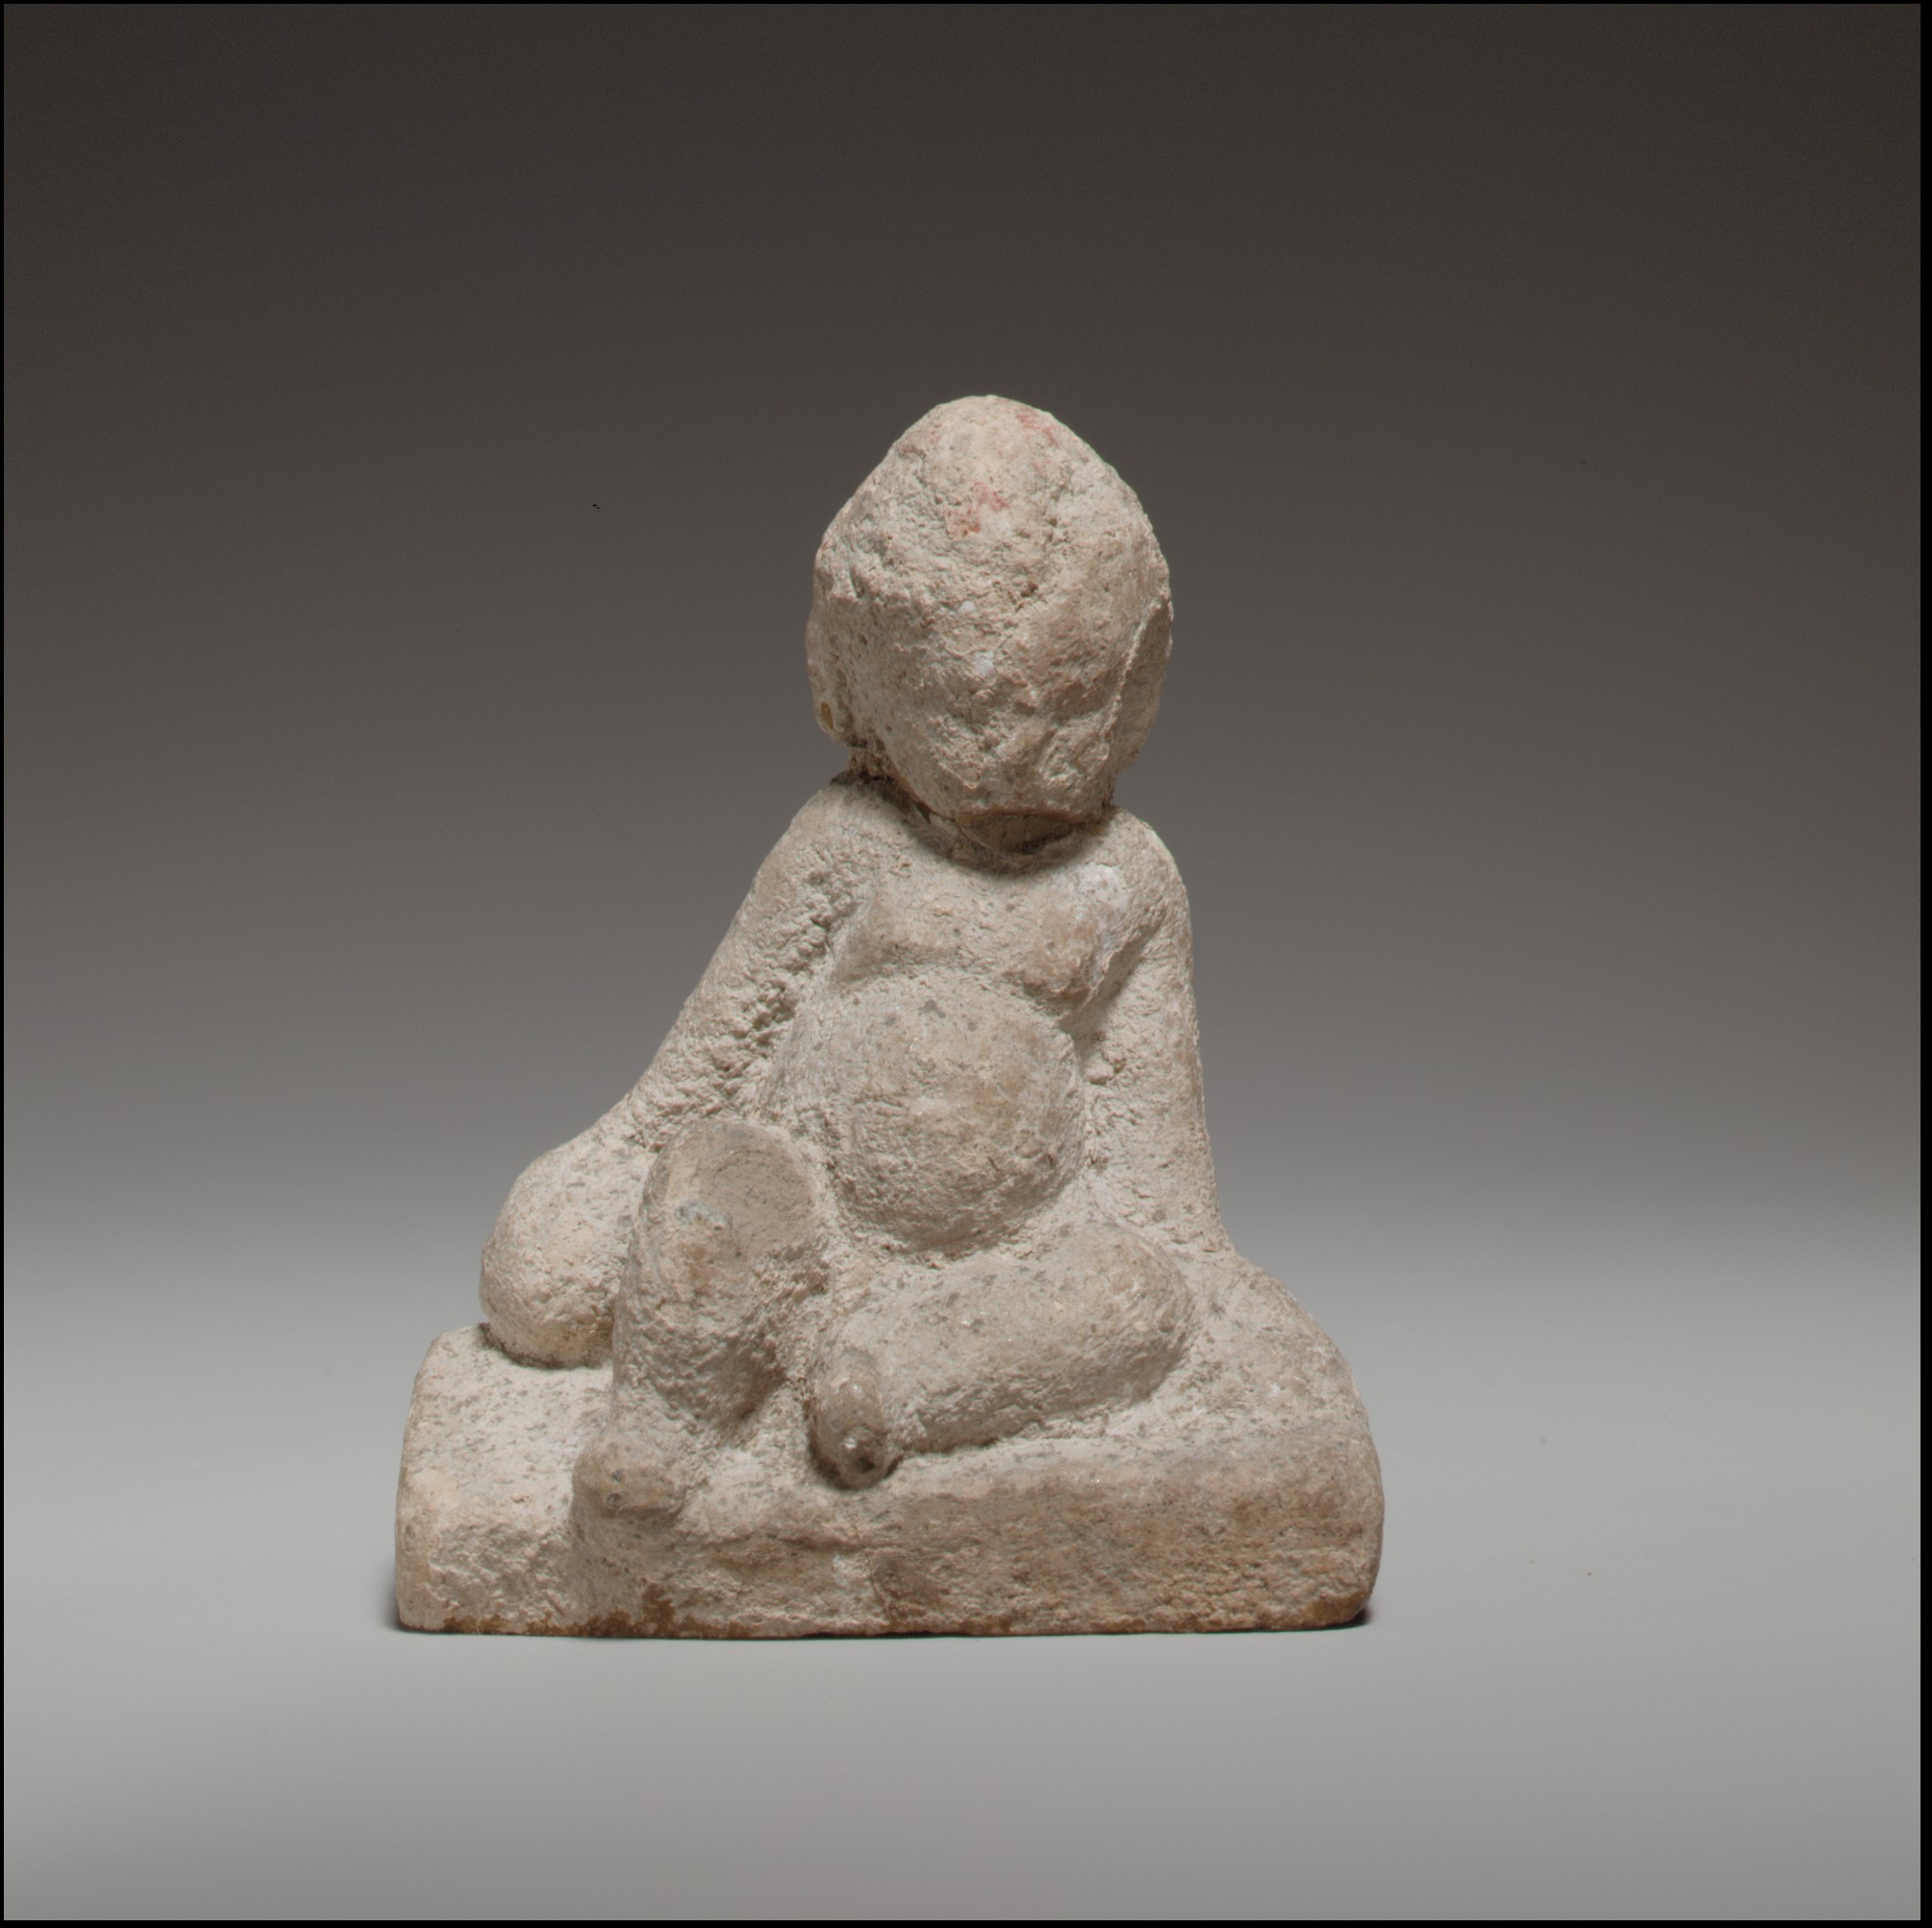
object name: statuette of eros holding an apple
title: Seated baby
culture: cypriot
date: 300-201 BCE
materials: terracotta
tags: infants